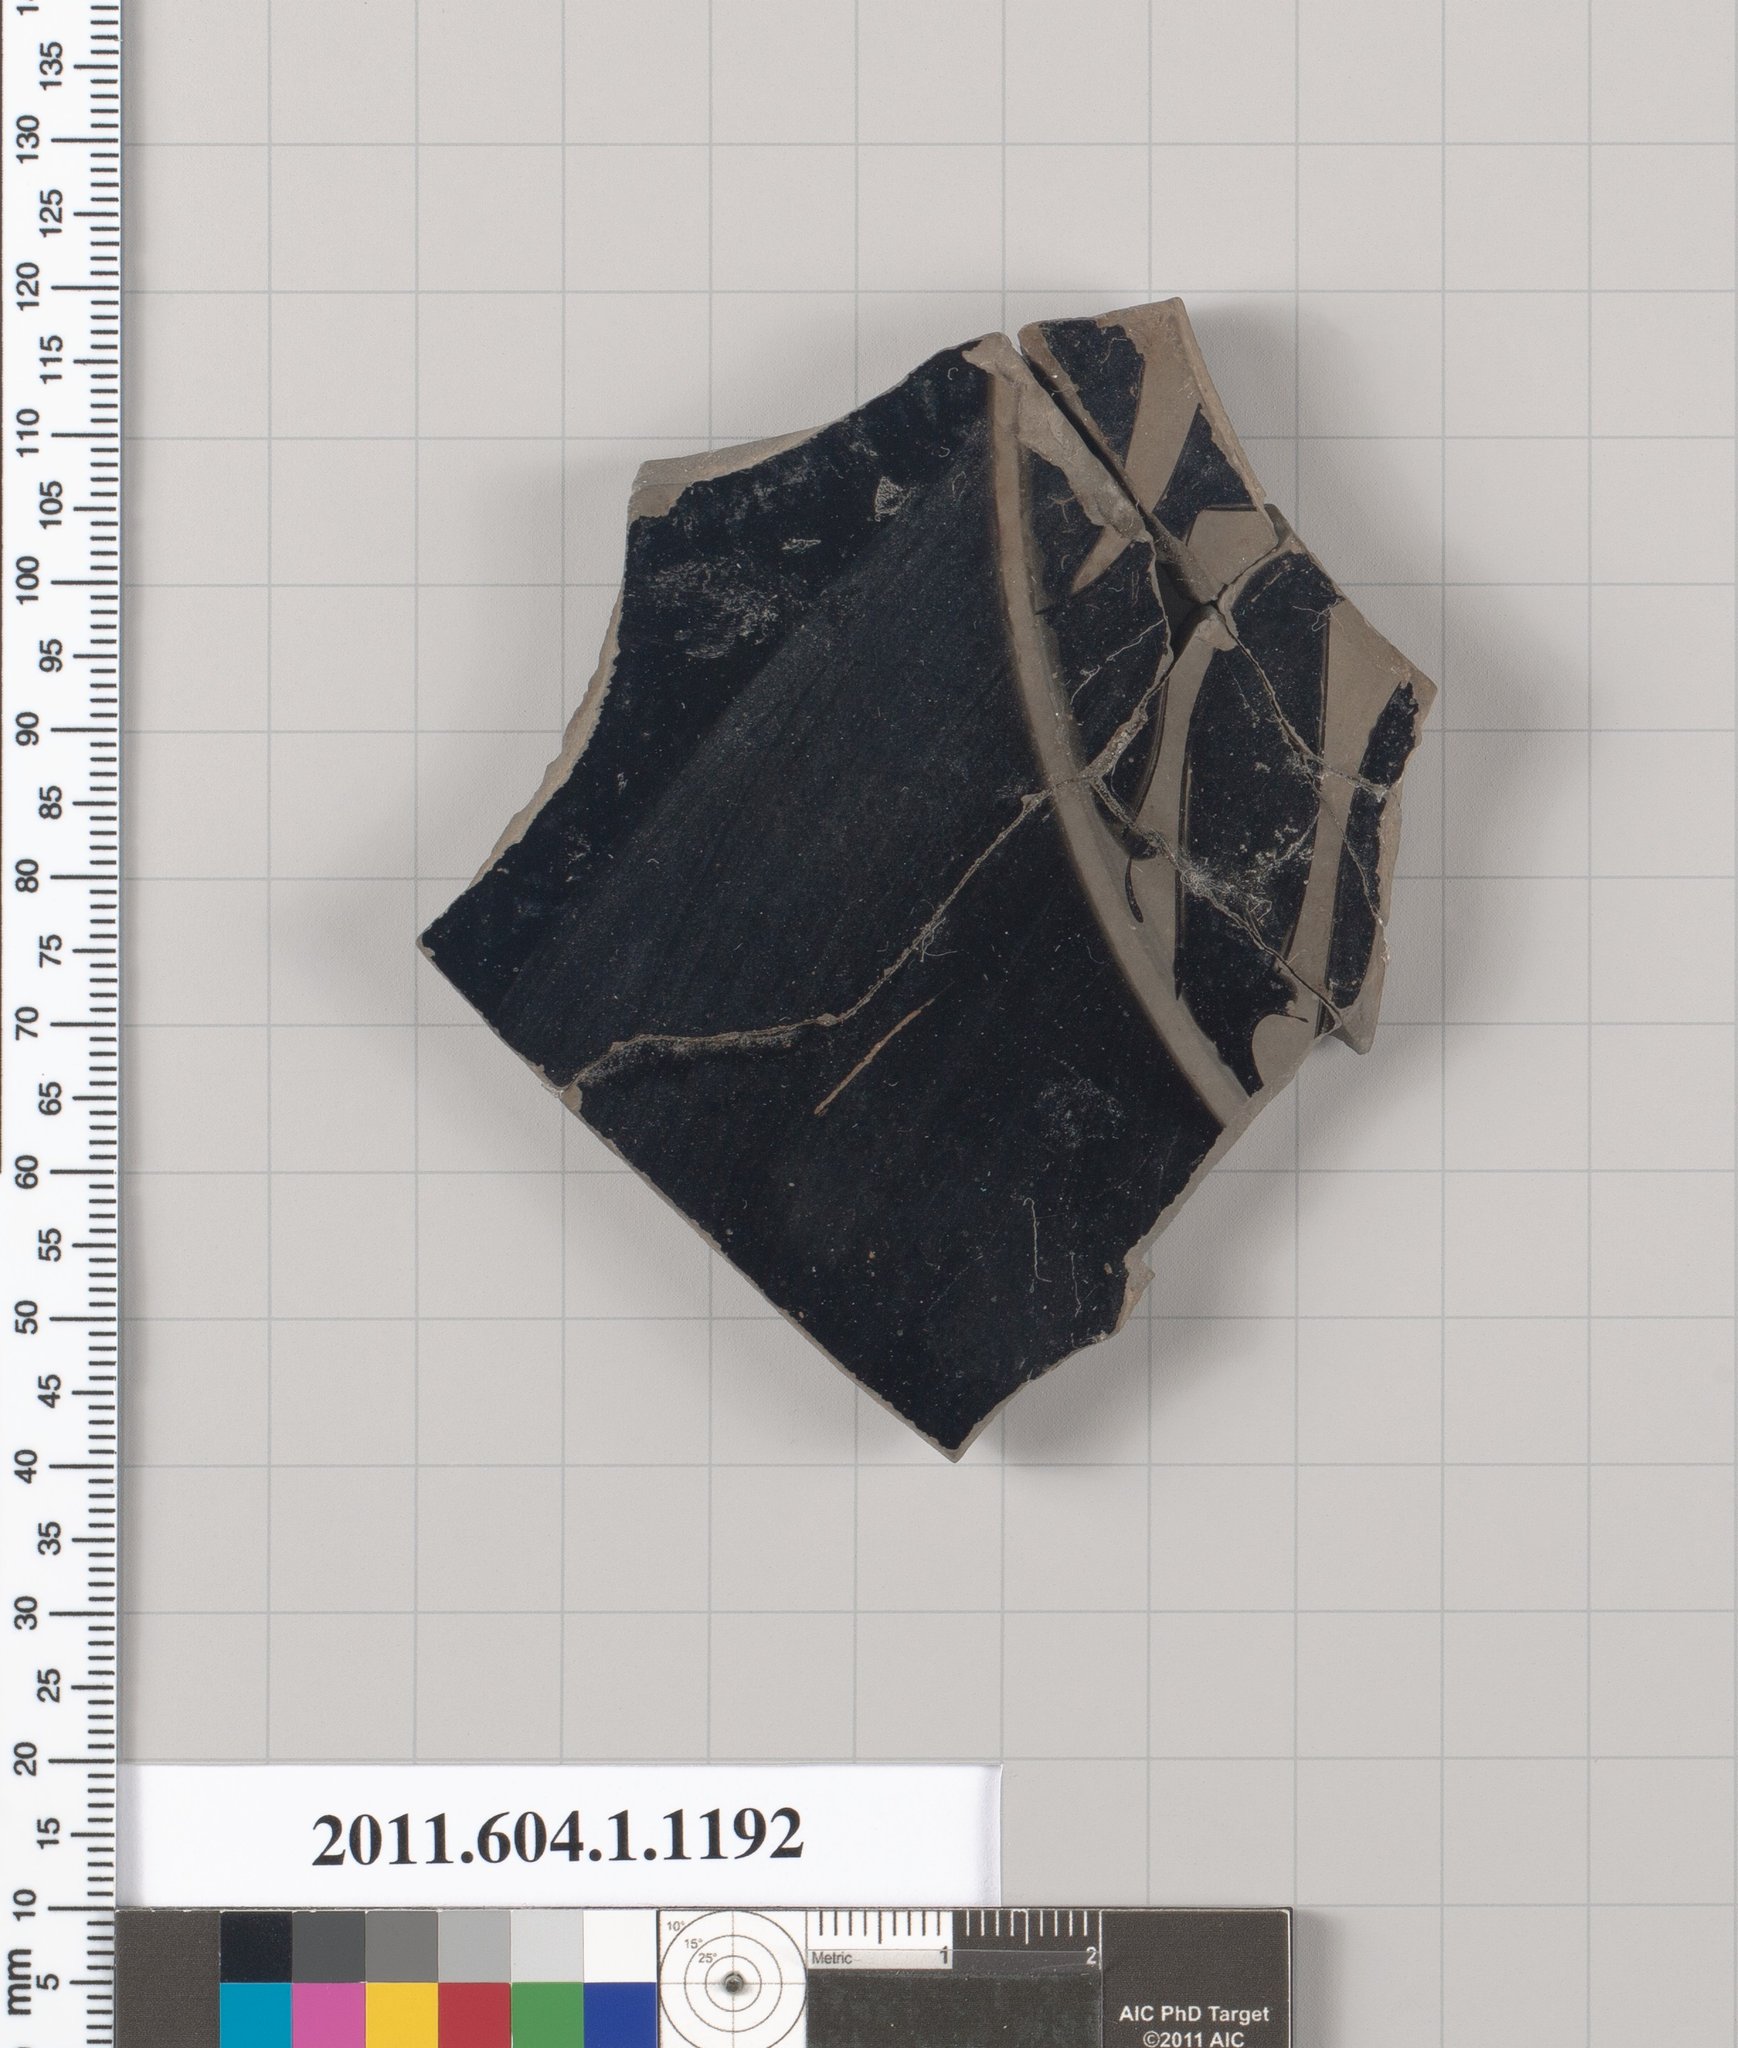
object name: kylix fragment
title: Terracotta fragment of a kylix (drinking cup)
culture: greek, attic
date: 520-500 BCE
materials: terracotta